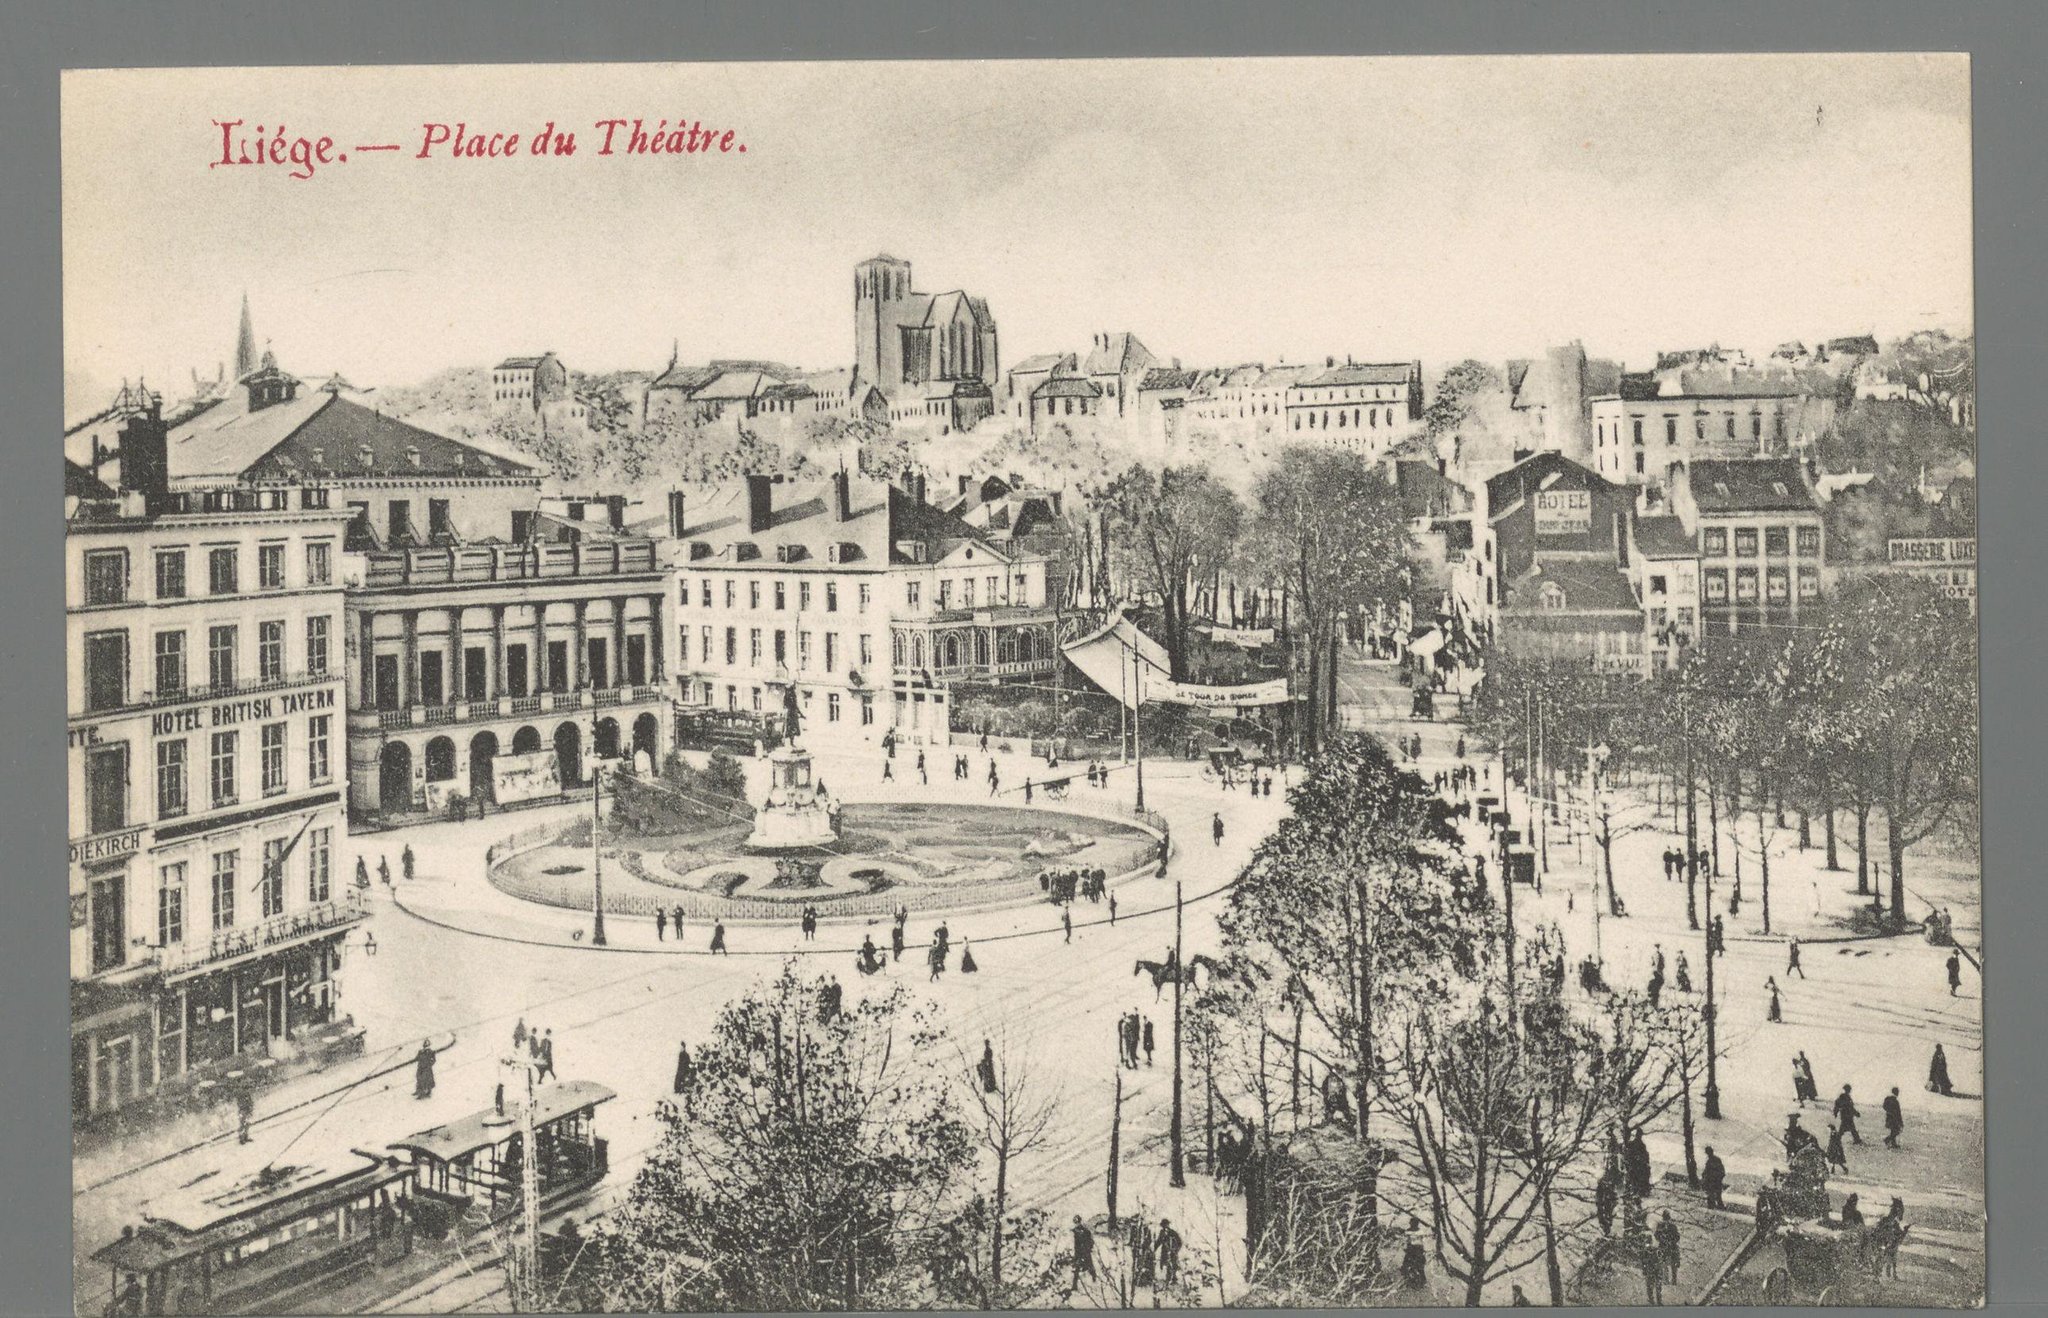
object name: photomechanical print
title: Liège. Place du Théâtre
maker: Anonymous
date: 1906-1930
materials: cardboard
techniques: photograph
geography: liège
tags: square, place, circus, etc., prospect of city, town panorama, silhouette of city (+ city(-scape) with figures, staffage), liège